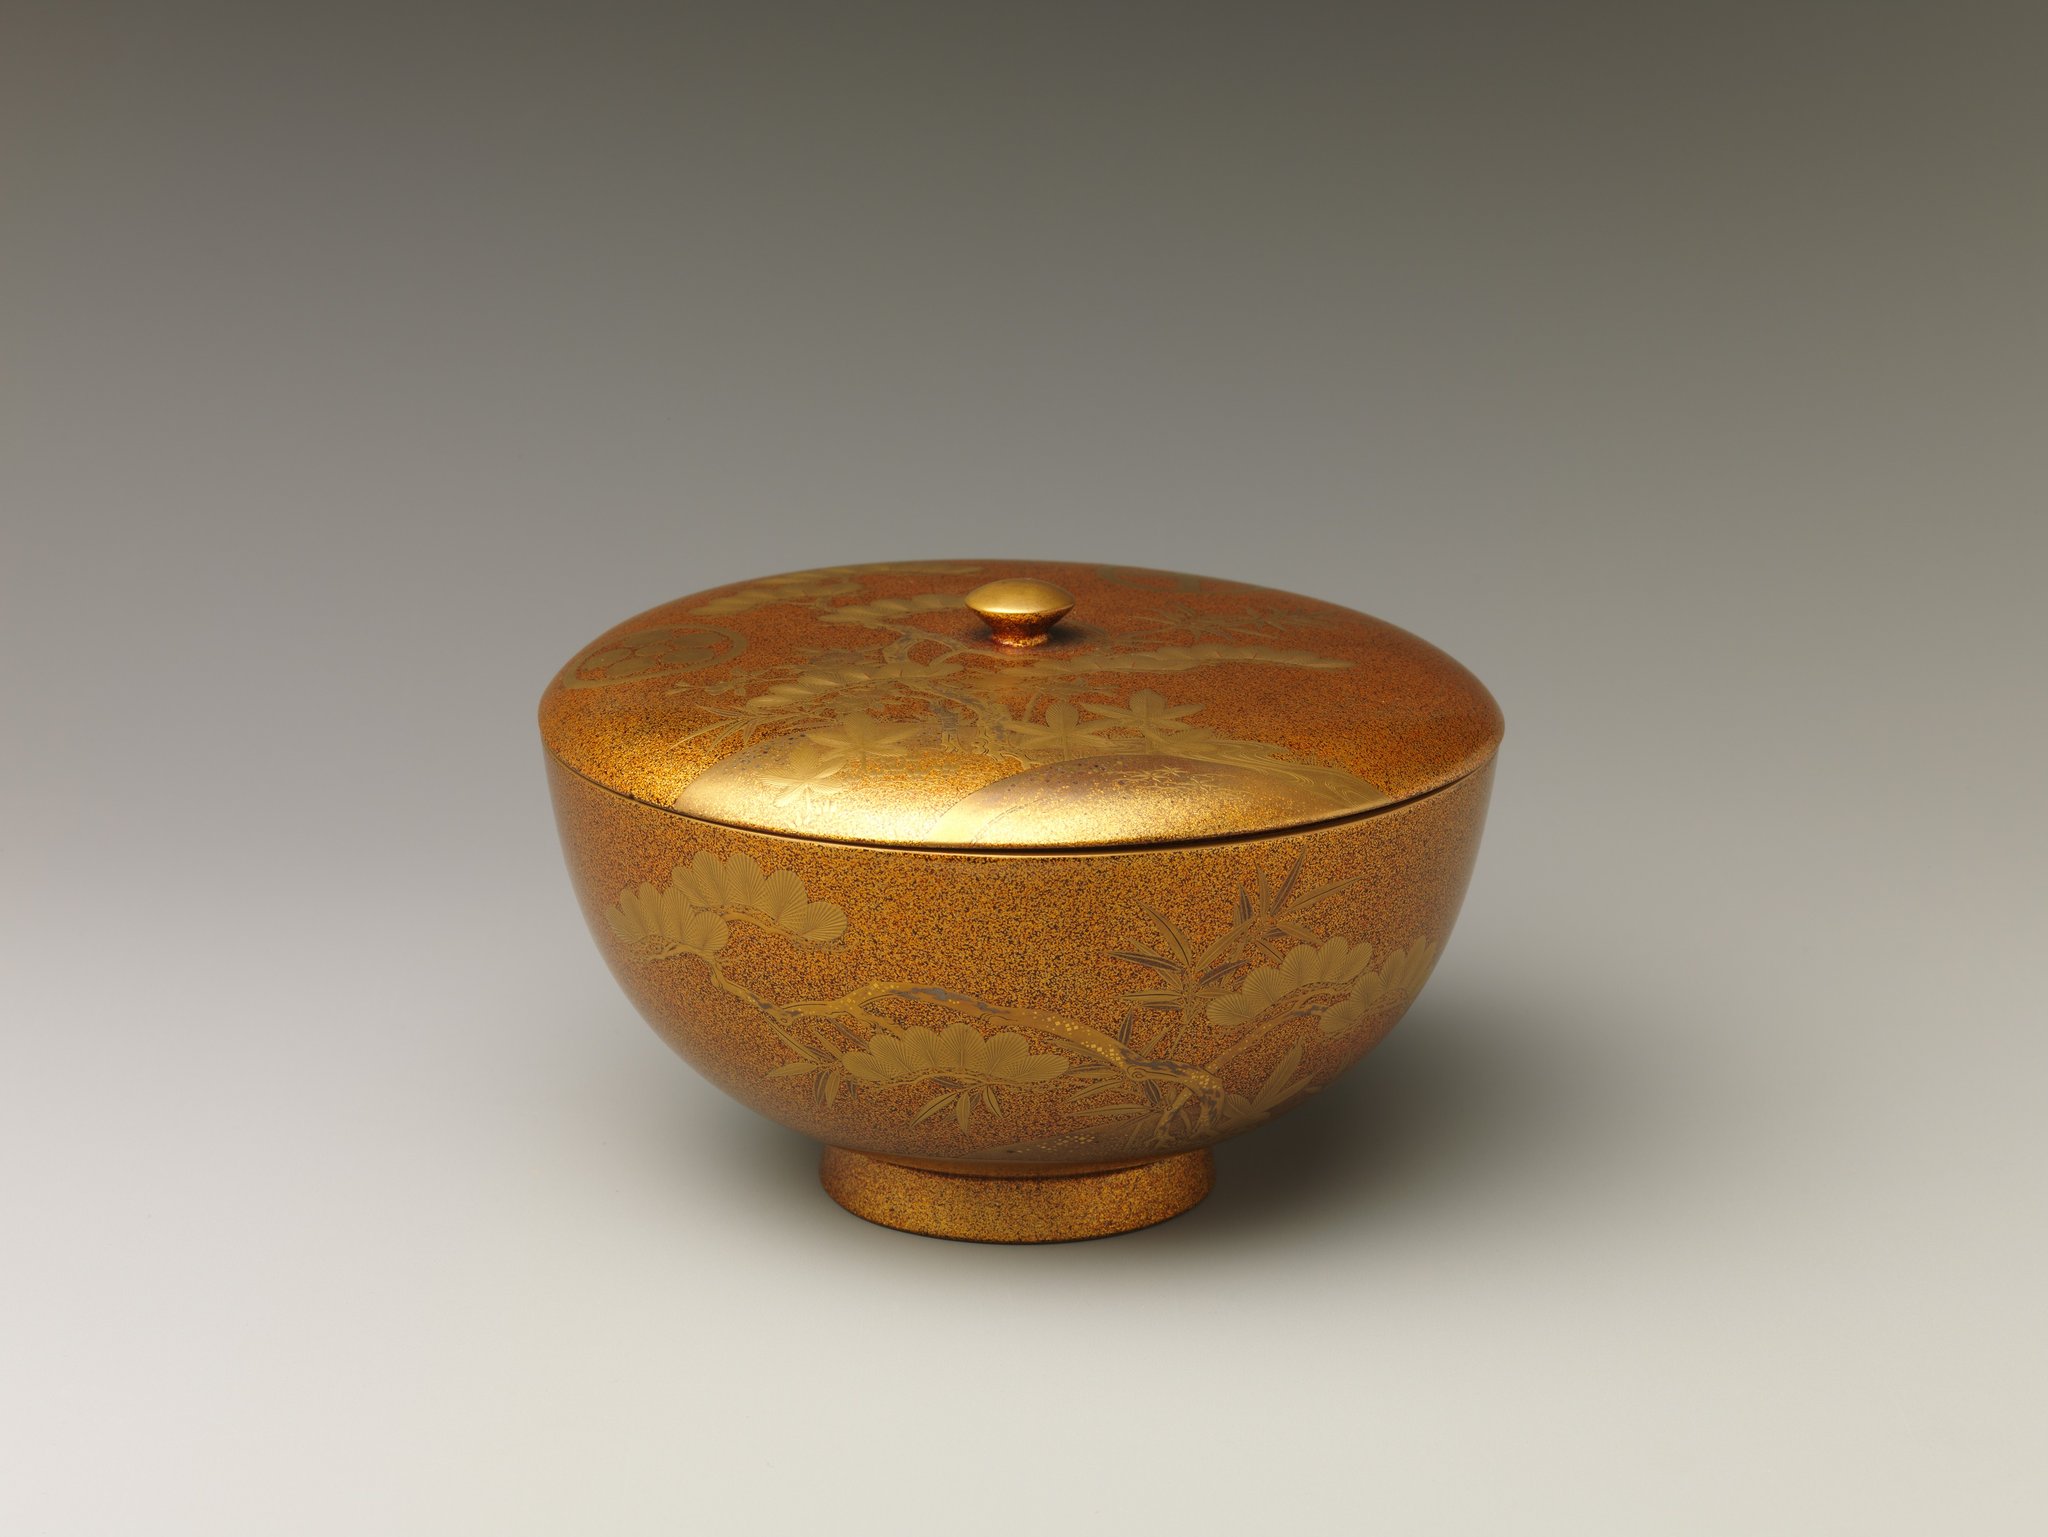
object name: bowl with cover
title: Covered Bowl with Design of Pine, Bamboo, and Cherry Blossom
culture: japanese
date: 1801-1900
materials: gold, lacquer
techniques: maki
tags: flowers,bamboo